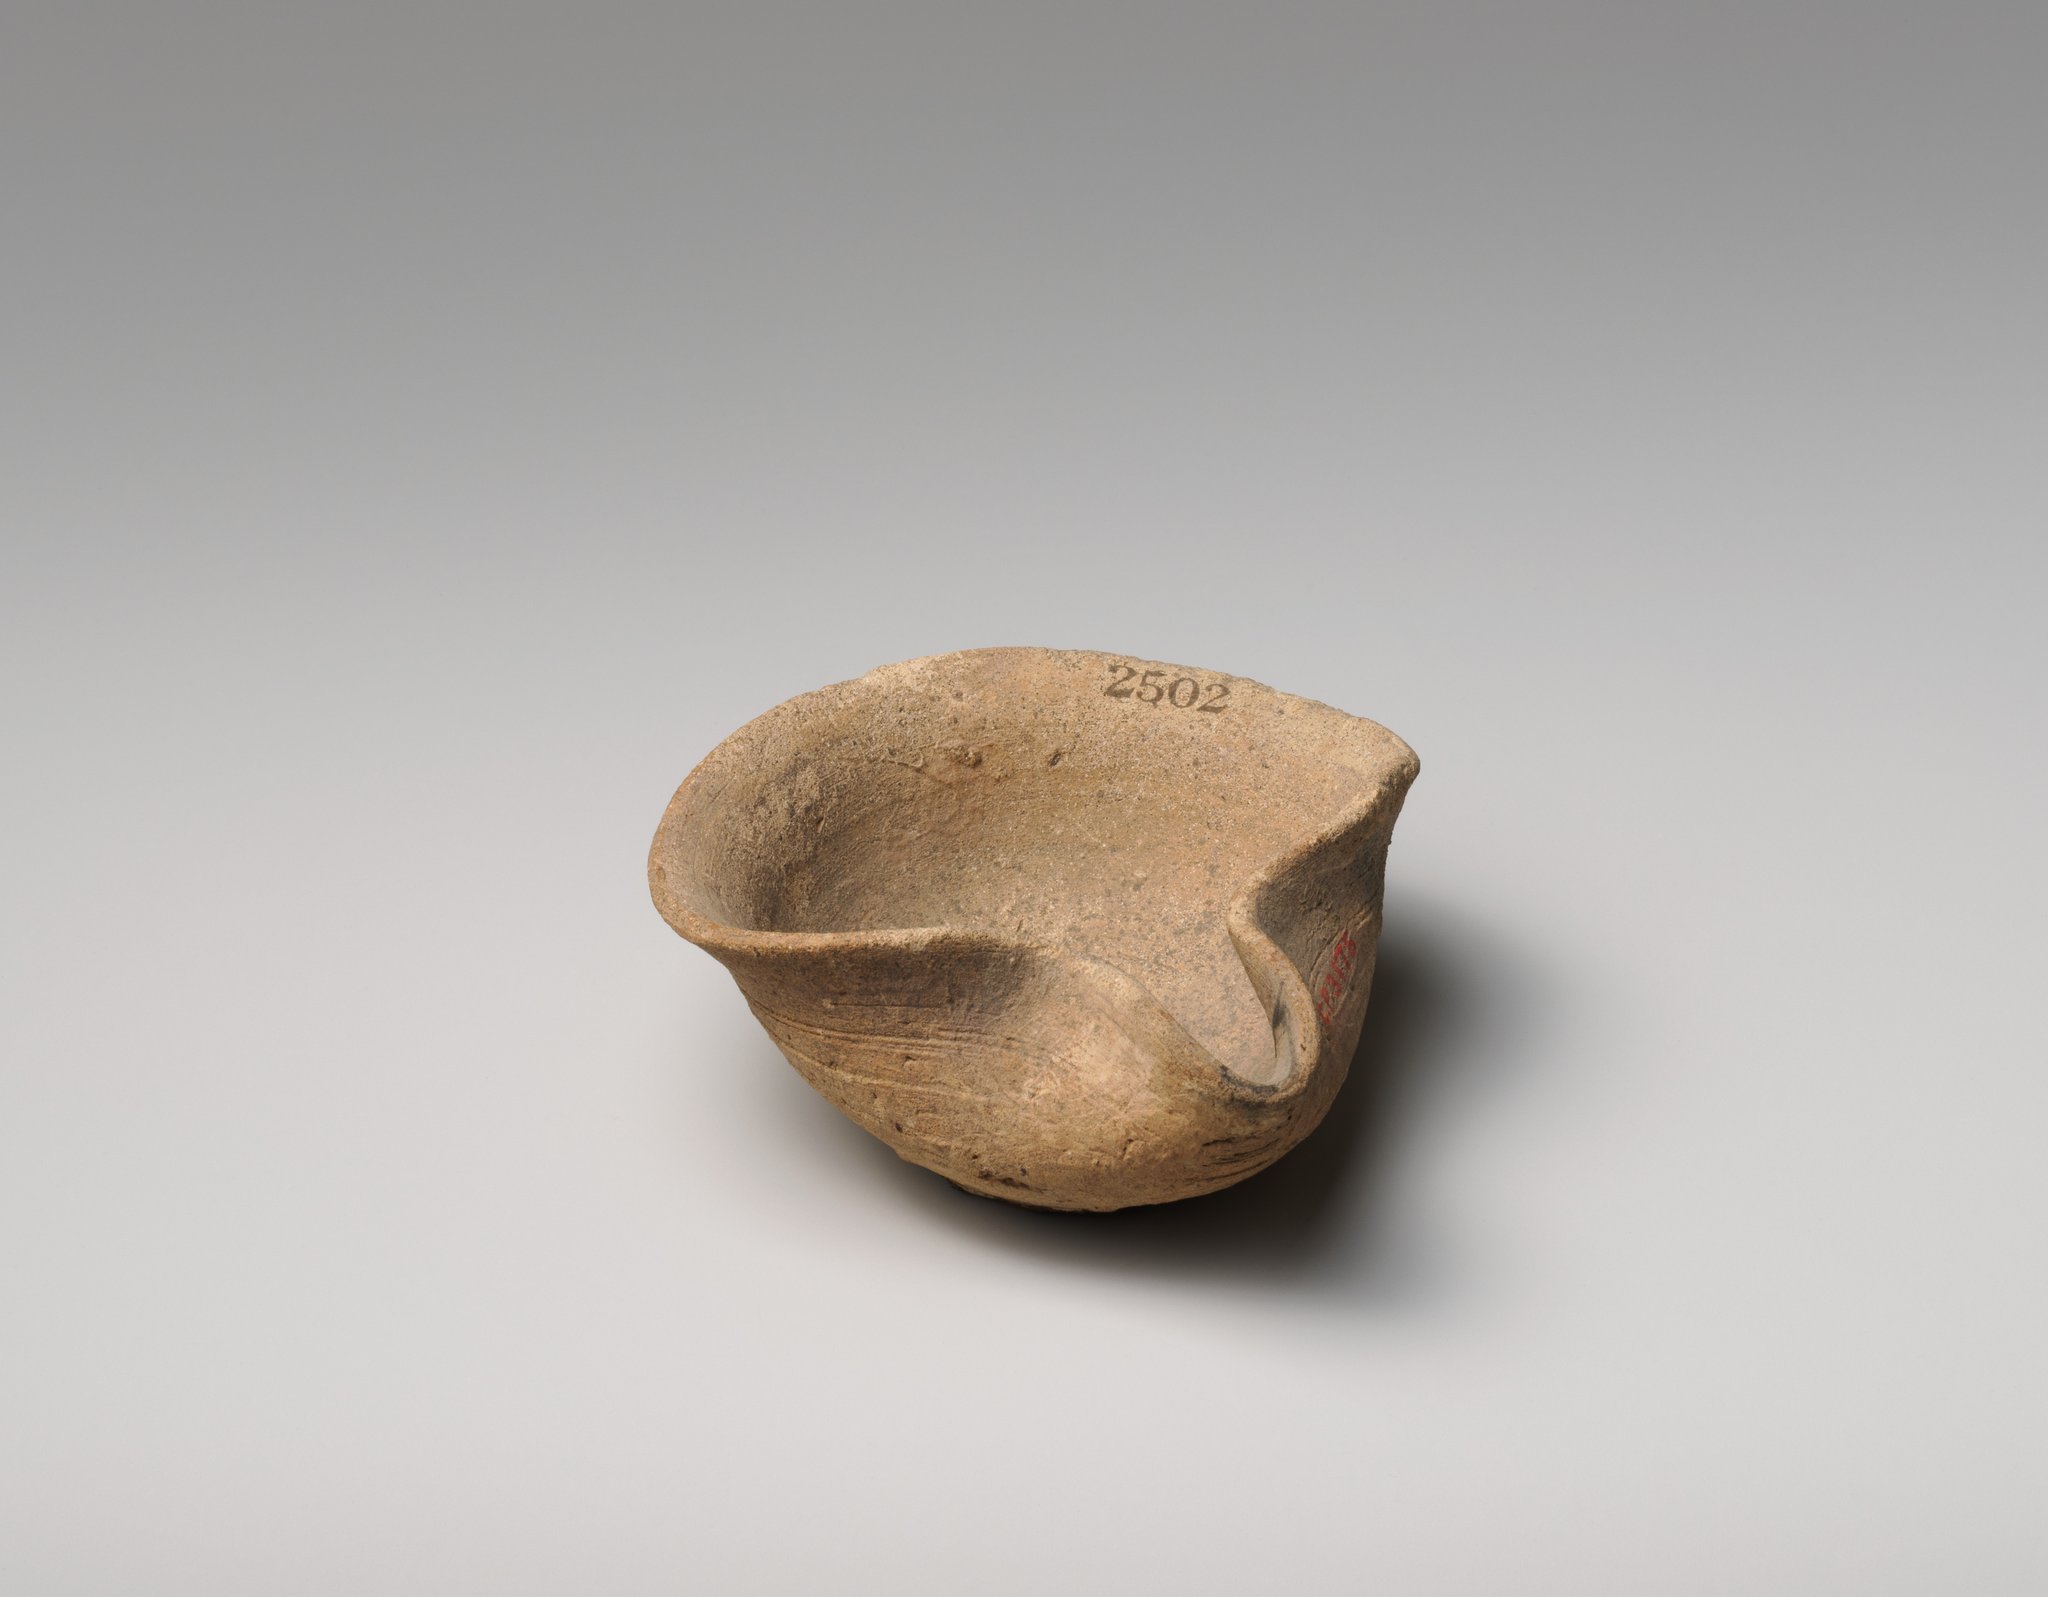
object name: lamp, saucer shaped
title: Terracotta saucer-shaped lamp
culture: cypriot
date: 400-301 BCE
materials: terracotta